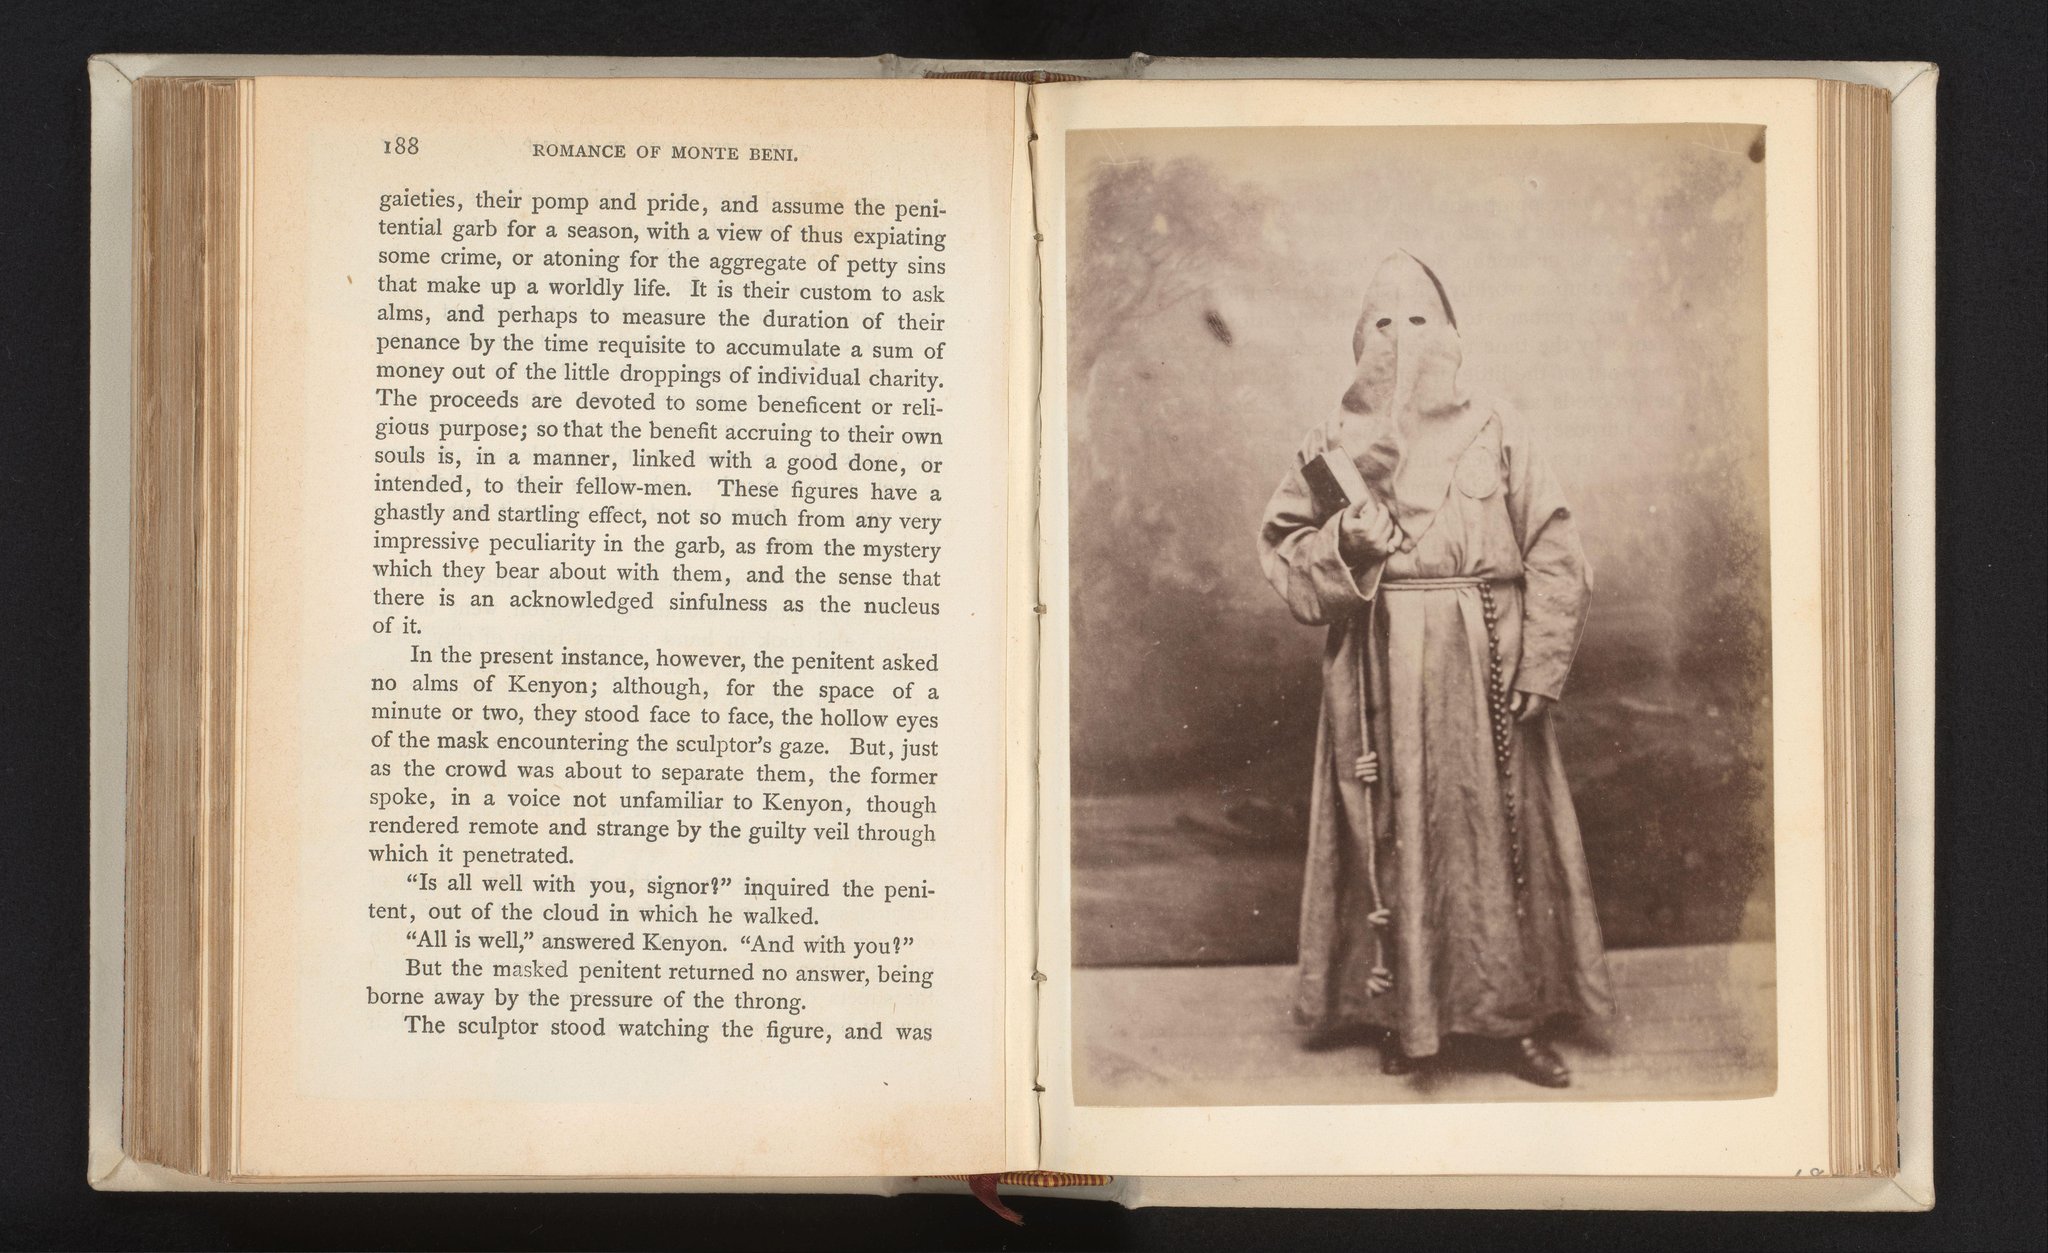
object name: page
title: Portret van iemand in een monnikspij en met een kap over het hoofd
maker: Anonymous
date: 1850-1860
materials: photographic support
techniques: albumen print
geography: italy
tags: monks and nuns